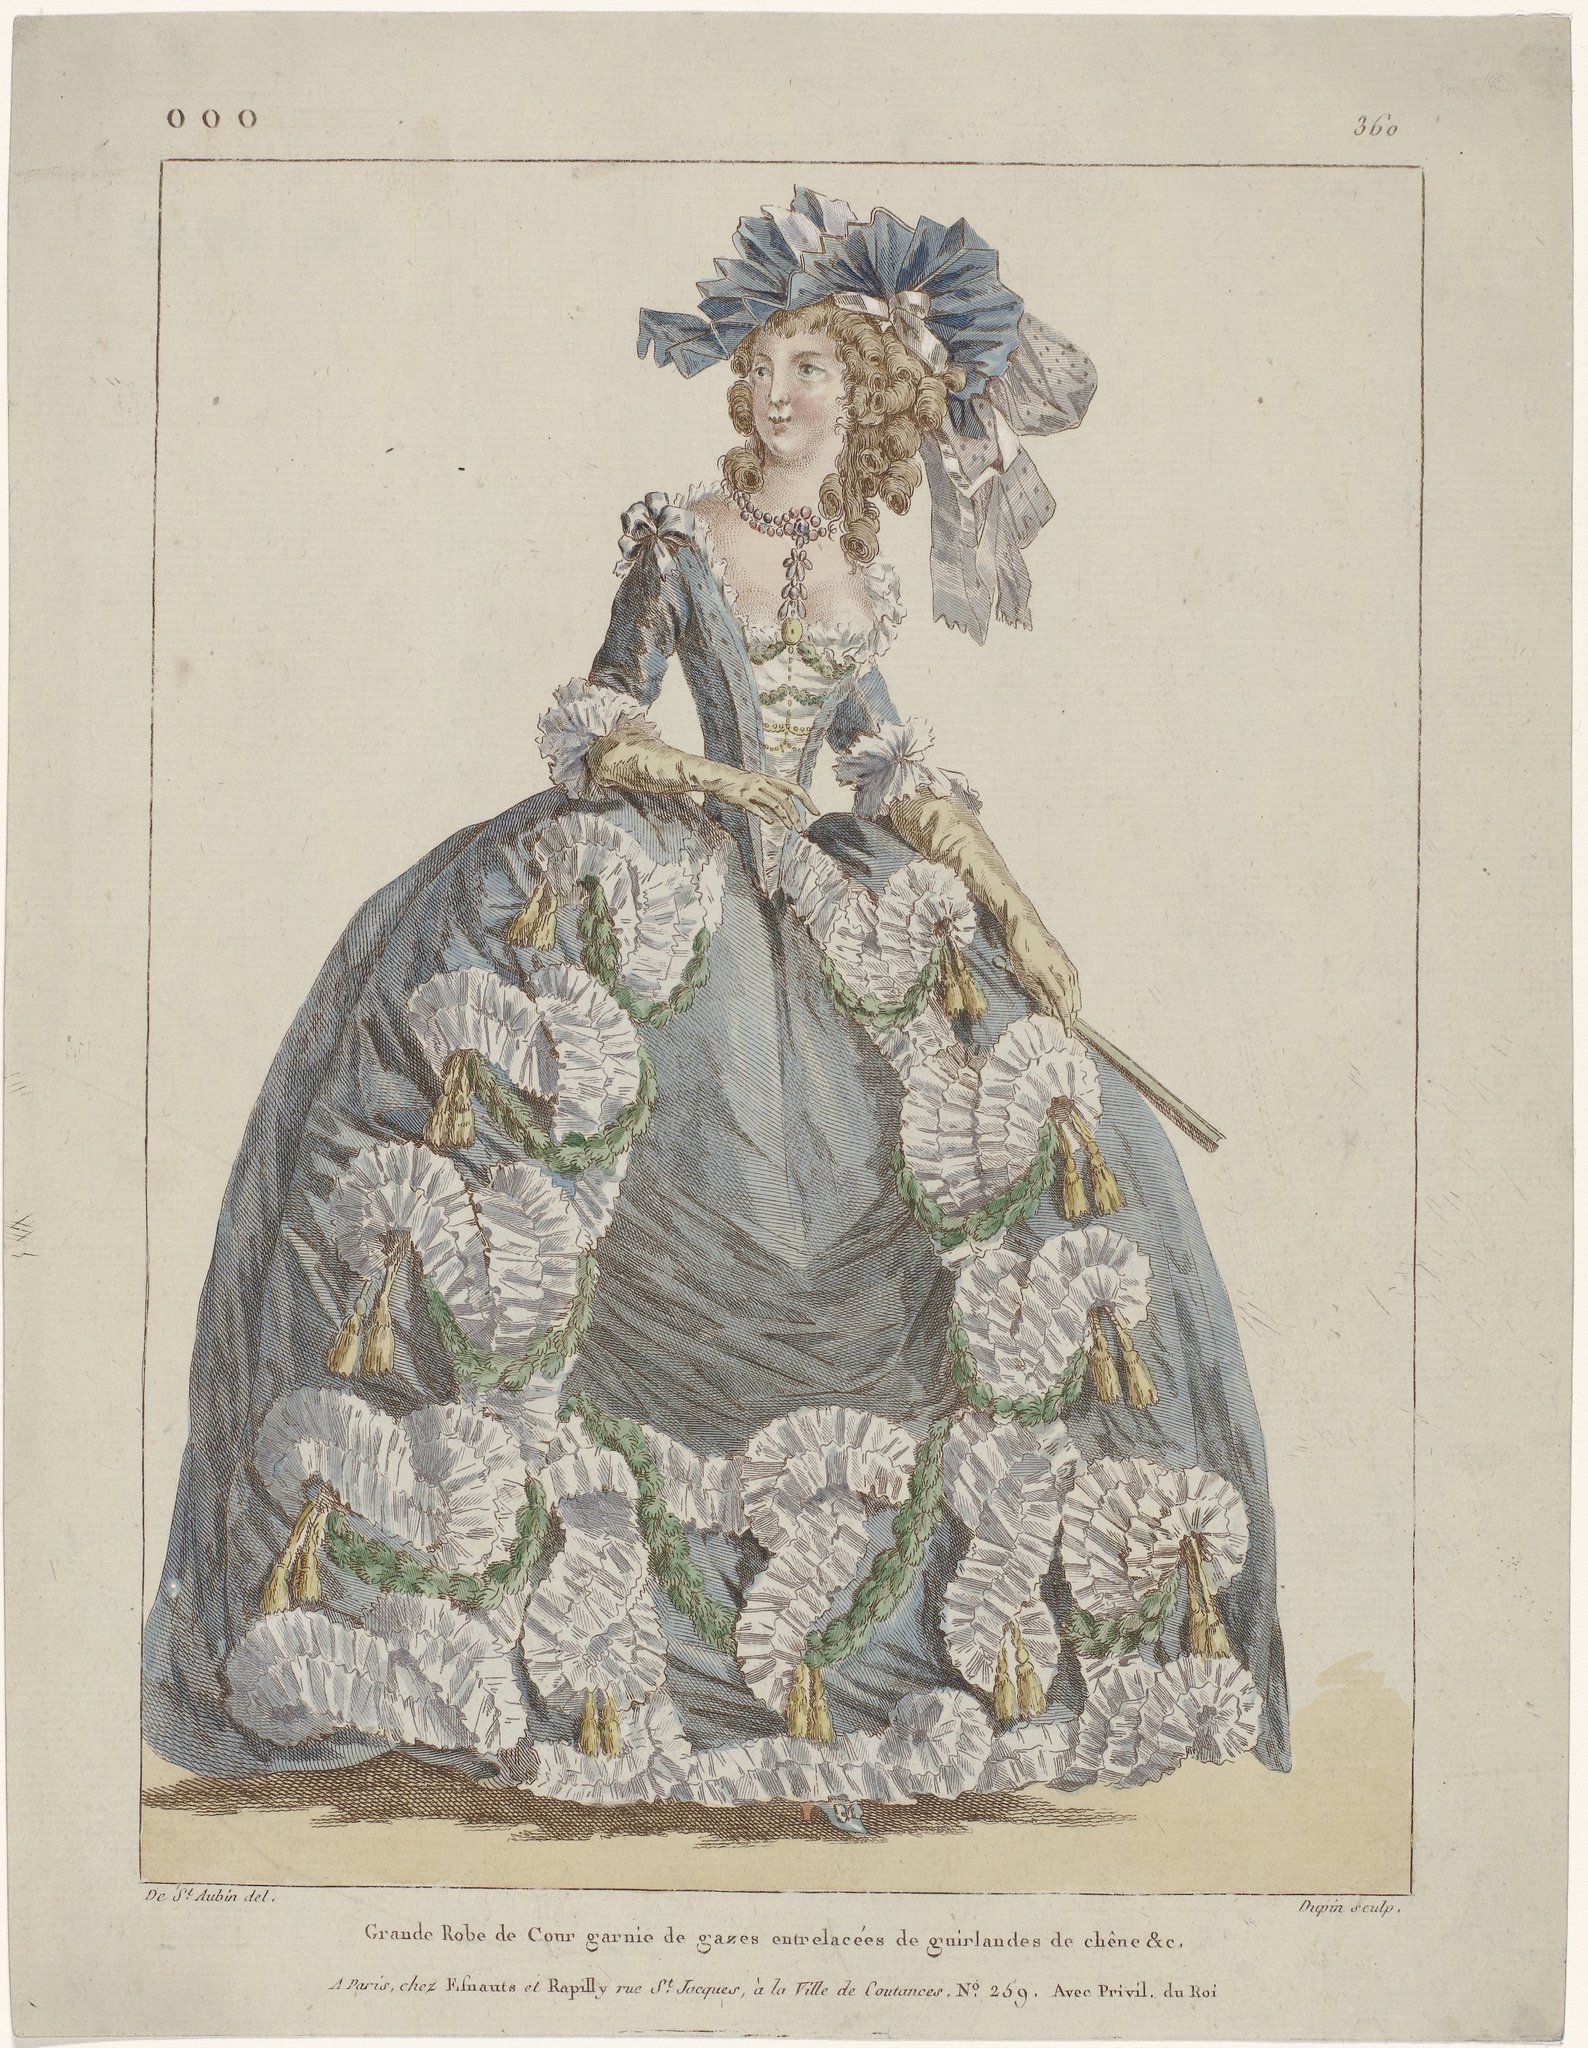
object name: fashion print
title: Gallerie des Modes et Costumes Français, 1787, ooo 360 : Grande Robe de Cour (...)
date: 1787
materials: paper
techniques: hand coloring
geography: paris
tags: dress, gown: court gown or court dress (+ women's clothes), gloves, mittens (long gloves) (+ women's clothes), ornamental parts of clothing (+ women's clothes), border, ribbon, braid (+ women's clothes), head-gear: cap (+ women's clothes), fashion plates, shoes, sandals (+ women's clothes), fan (+ women's clothes), necklace (+ women's clothes)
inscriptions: caption: ‘Grande Robe de Cour garnie de gazes entrelacées de guirlandes de chêne & c.’, address: ‘A Paris chez Esnauts et Rapilly, rue St. Jacques, à la Ville de Coutances, No. 259. Avec Privil. du Roi.’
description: Staande vrouw gekleed in een 'grande Robe de Cour' (hofjapon), versierd met gerimpelde stroken tule, verweven met guirlandes van eikenbladeren en kwasten. Accessoires: geplooide muts met gestippeld lint, collier, lange handschoenen, waaier, schoen met contrasterende hak en strik. Prent uit de serie ooo. 1er cahier de grandes robes d'étiquette de cour de la France faisant suite aux costumes français, Gallerie des Modes et Costumes Français.